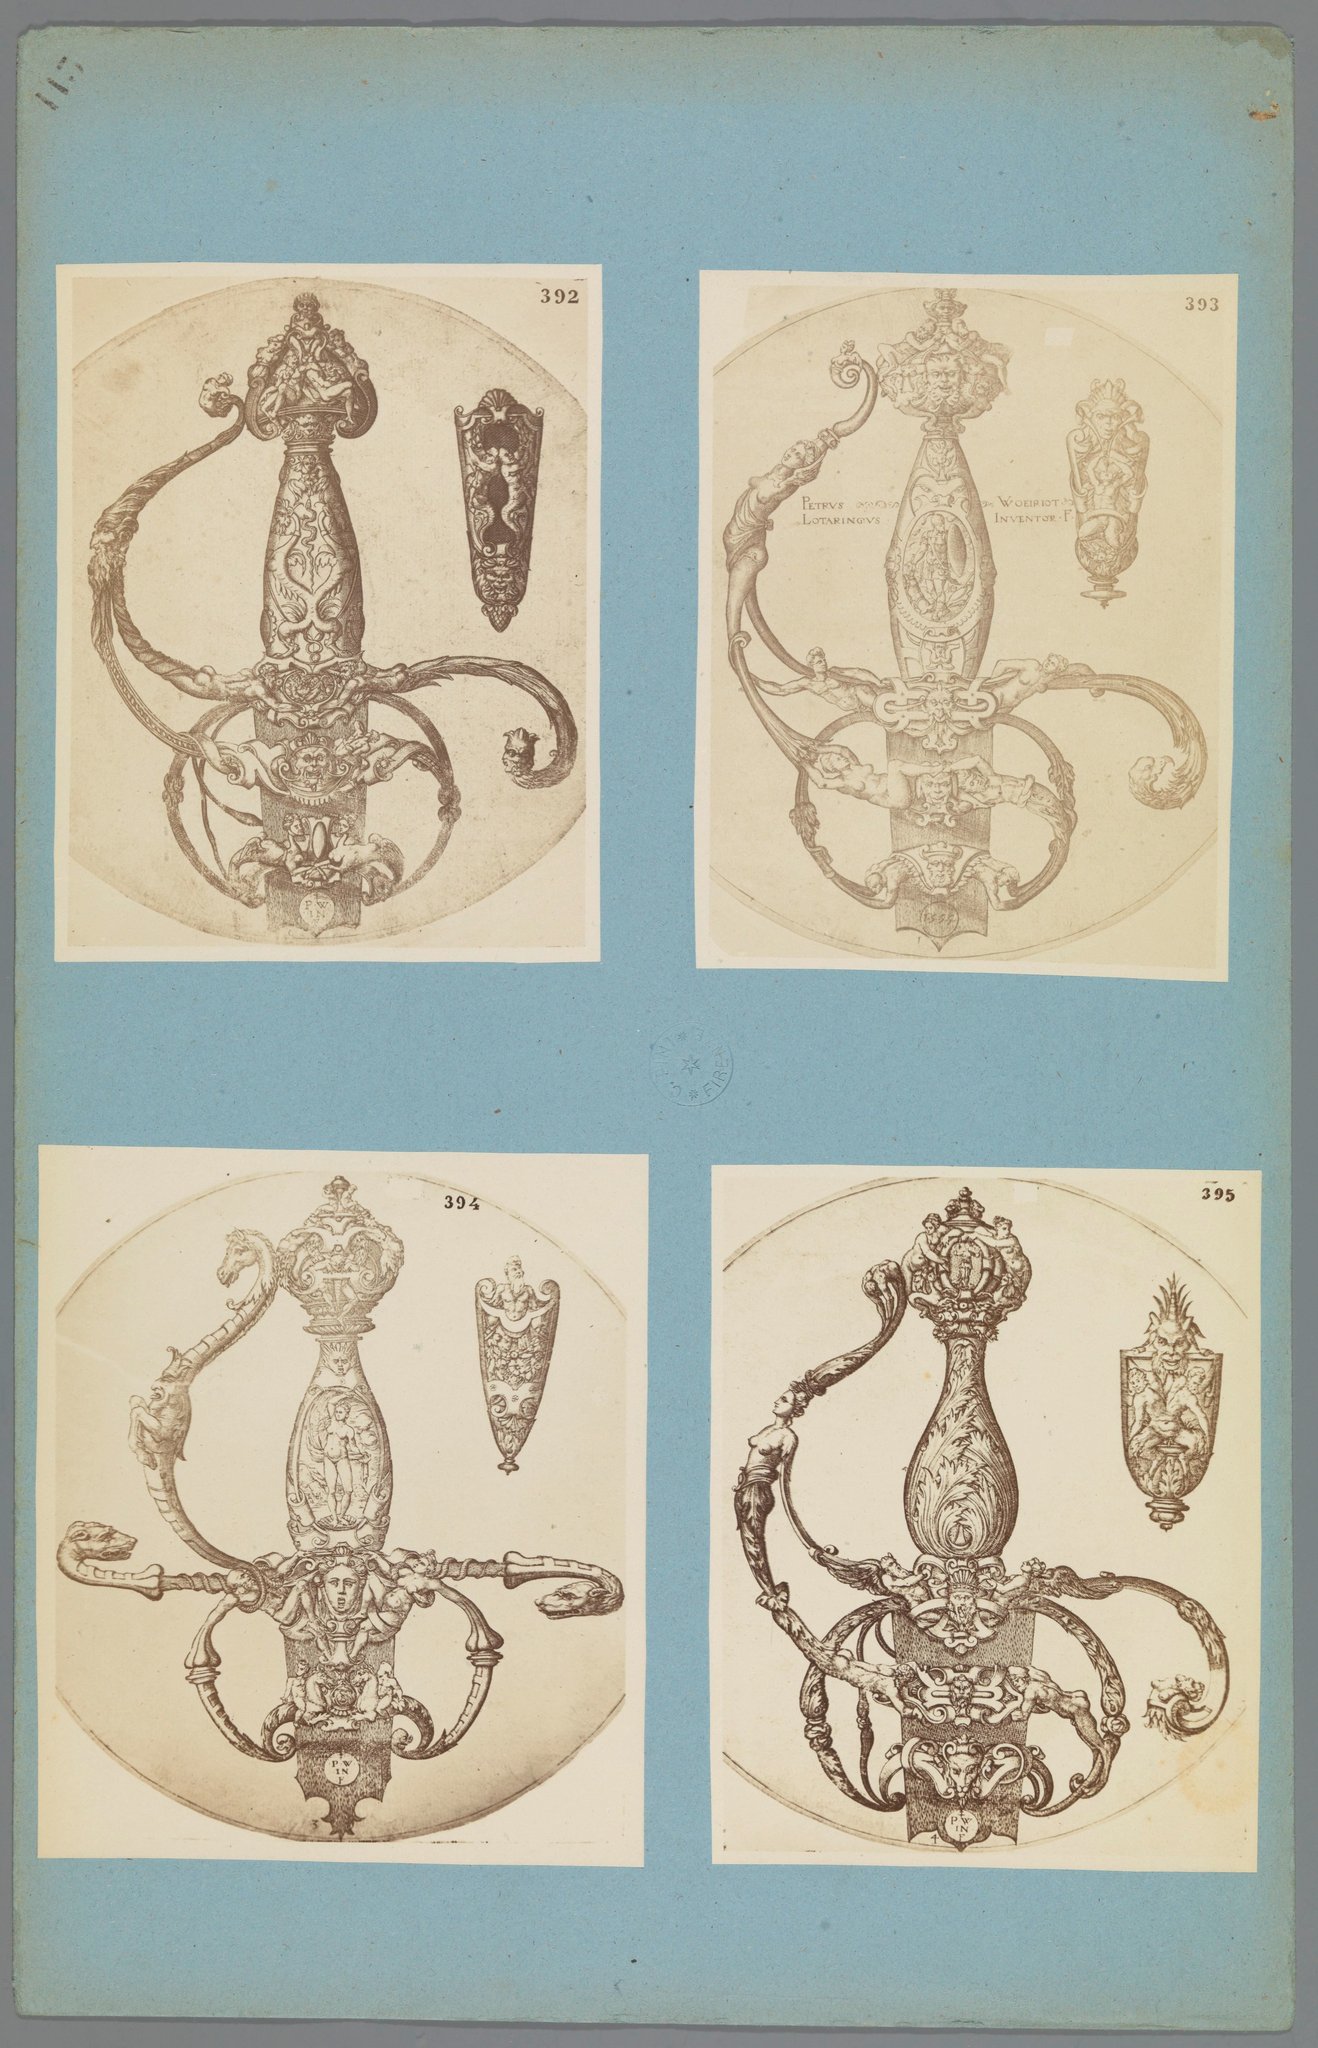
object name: reproduction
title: Vier fotoreproducties van prenten van zwaardgevesten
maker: Anonymous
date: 1875-1900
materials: cardboard, photographic support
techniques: albumen print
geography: europe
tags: anthropomorphic ornament, ram's head ~ ornament, hacking and thrusting weapons: sword, mask, mascaron ~ ornament, europe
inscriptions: name: ‘C. PINI FIRENZE’, number: ‘392’, number: ‘393’, number: ‘113’, collector's mark: Lugt 3937, number: ‘394’, number: ‘395’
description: Linksboven (392) een prent van een zwaardgevest met fantasiewezens, linksonder (394) een prent van een zwaardgevest met hondenkoppen, rechtsboven (393) een prent van een zwaardgevest met menselijke figuren, rechtsonder (395) een prent voorstellende een zwaardgevest met menselijke figuren en acanthusbladeren.